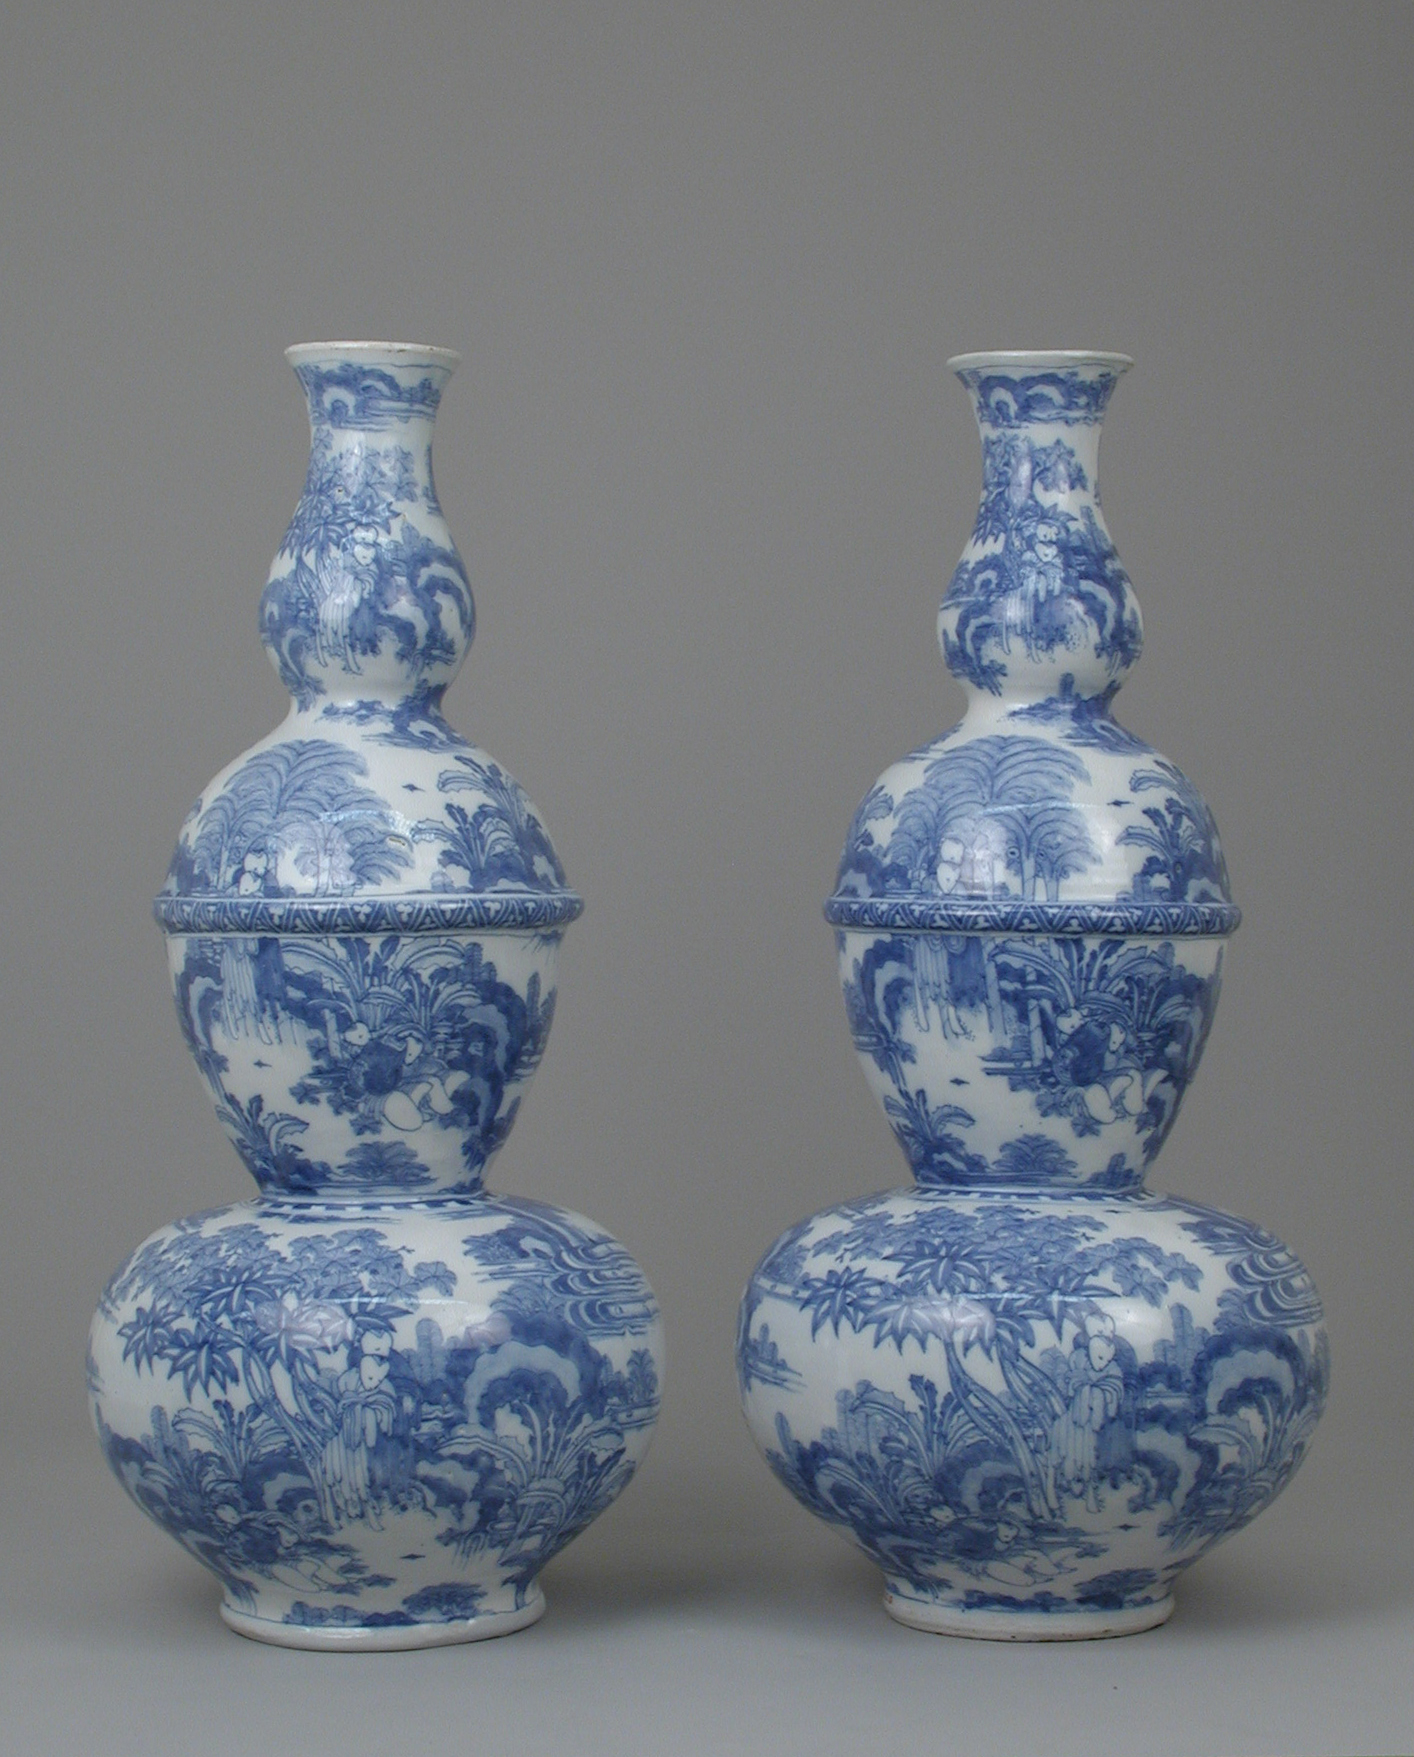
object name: vase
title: Pair of "triple-gourd" vases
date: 1667-1733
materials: earthenware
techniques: glazing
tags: flowers,trees